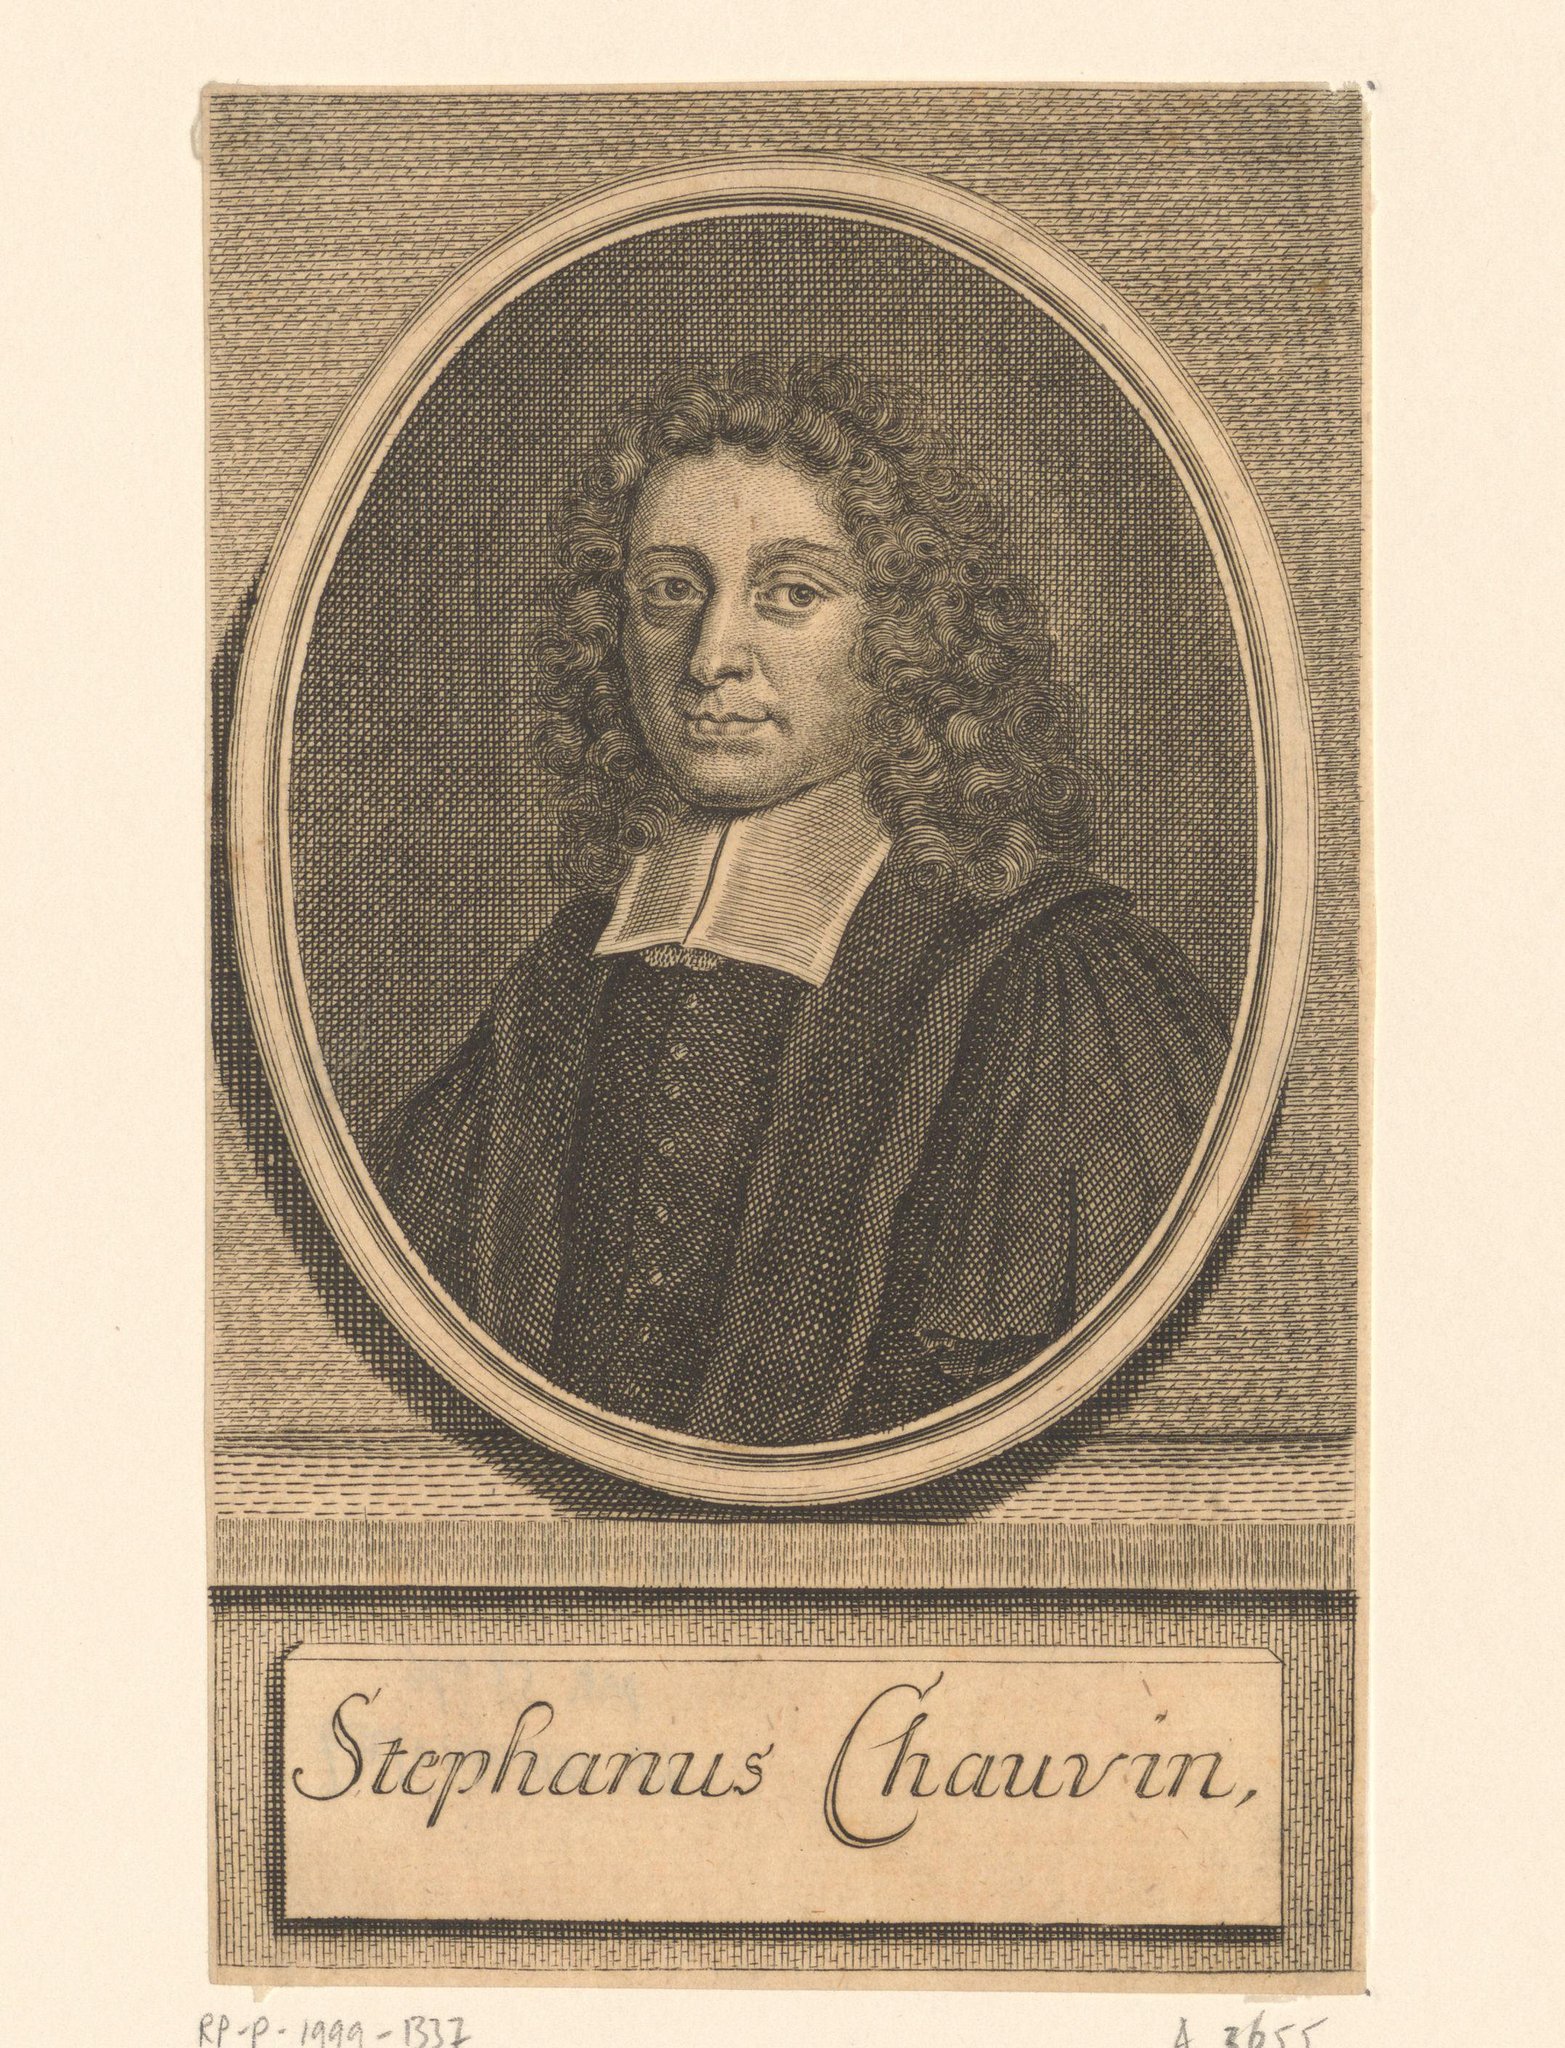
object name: print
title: Portret van Étienne Chauvin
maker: martin bernigeroth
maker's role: print maker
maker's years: 1670-1733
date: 1714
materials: paper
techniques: engraving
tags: historical persons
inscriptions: collector's mark: Lugt 2282, collector's mark: Lugt 2760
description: Prent mogelijk uit: Deutsche Acta Eruditorum. Leipzig: Johann Friedrich Gleditsch en Johann Gottlieb Gleditsch, 1714.